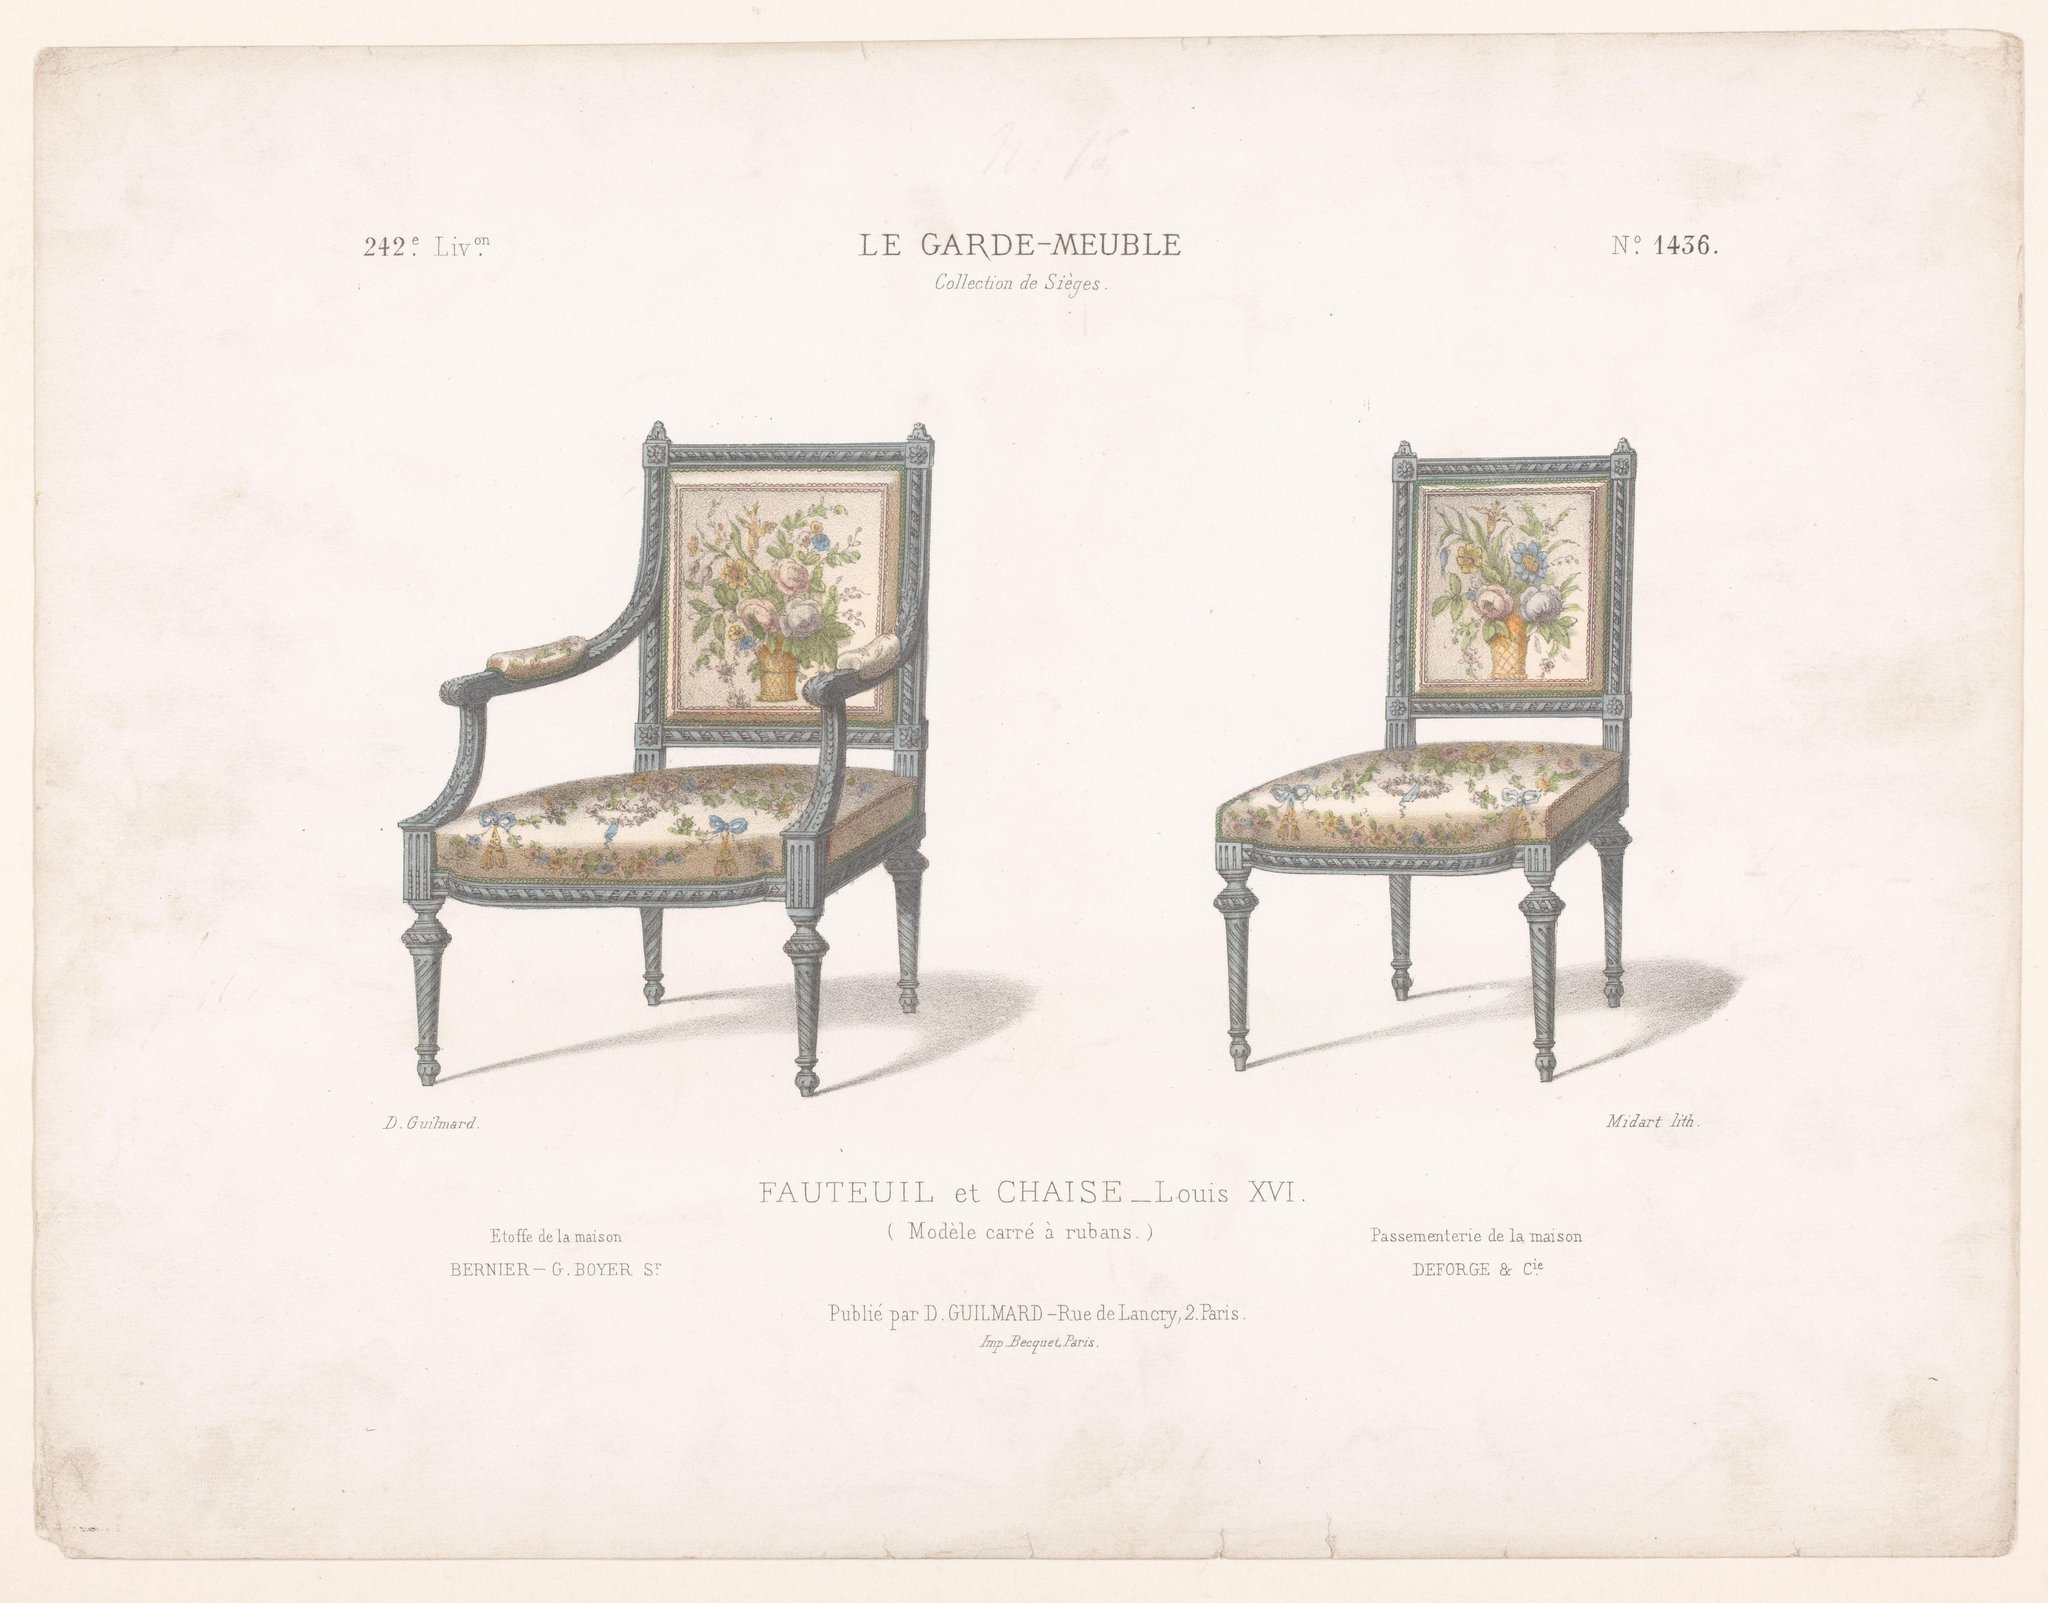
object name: print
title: Le garde-meuble / Collection de Sièges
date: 1839-1885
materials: paper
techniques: hand coloring, lithograph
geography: paris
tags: seating furniture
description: Ieder Livraison in de serie Le Garde-Meuble bevat negen platen: drie 'sièges' (zitmeubels), drie 'meubles' (diverse meubels zoals tafels en kasten) en drie 'tentures' (gordijnen en draperieën).